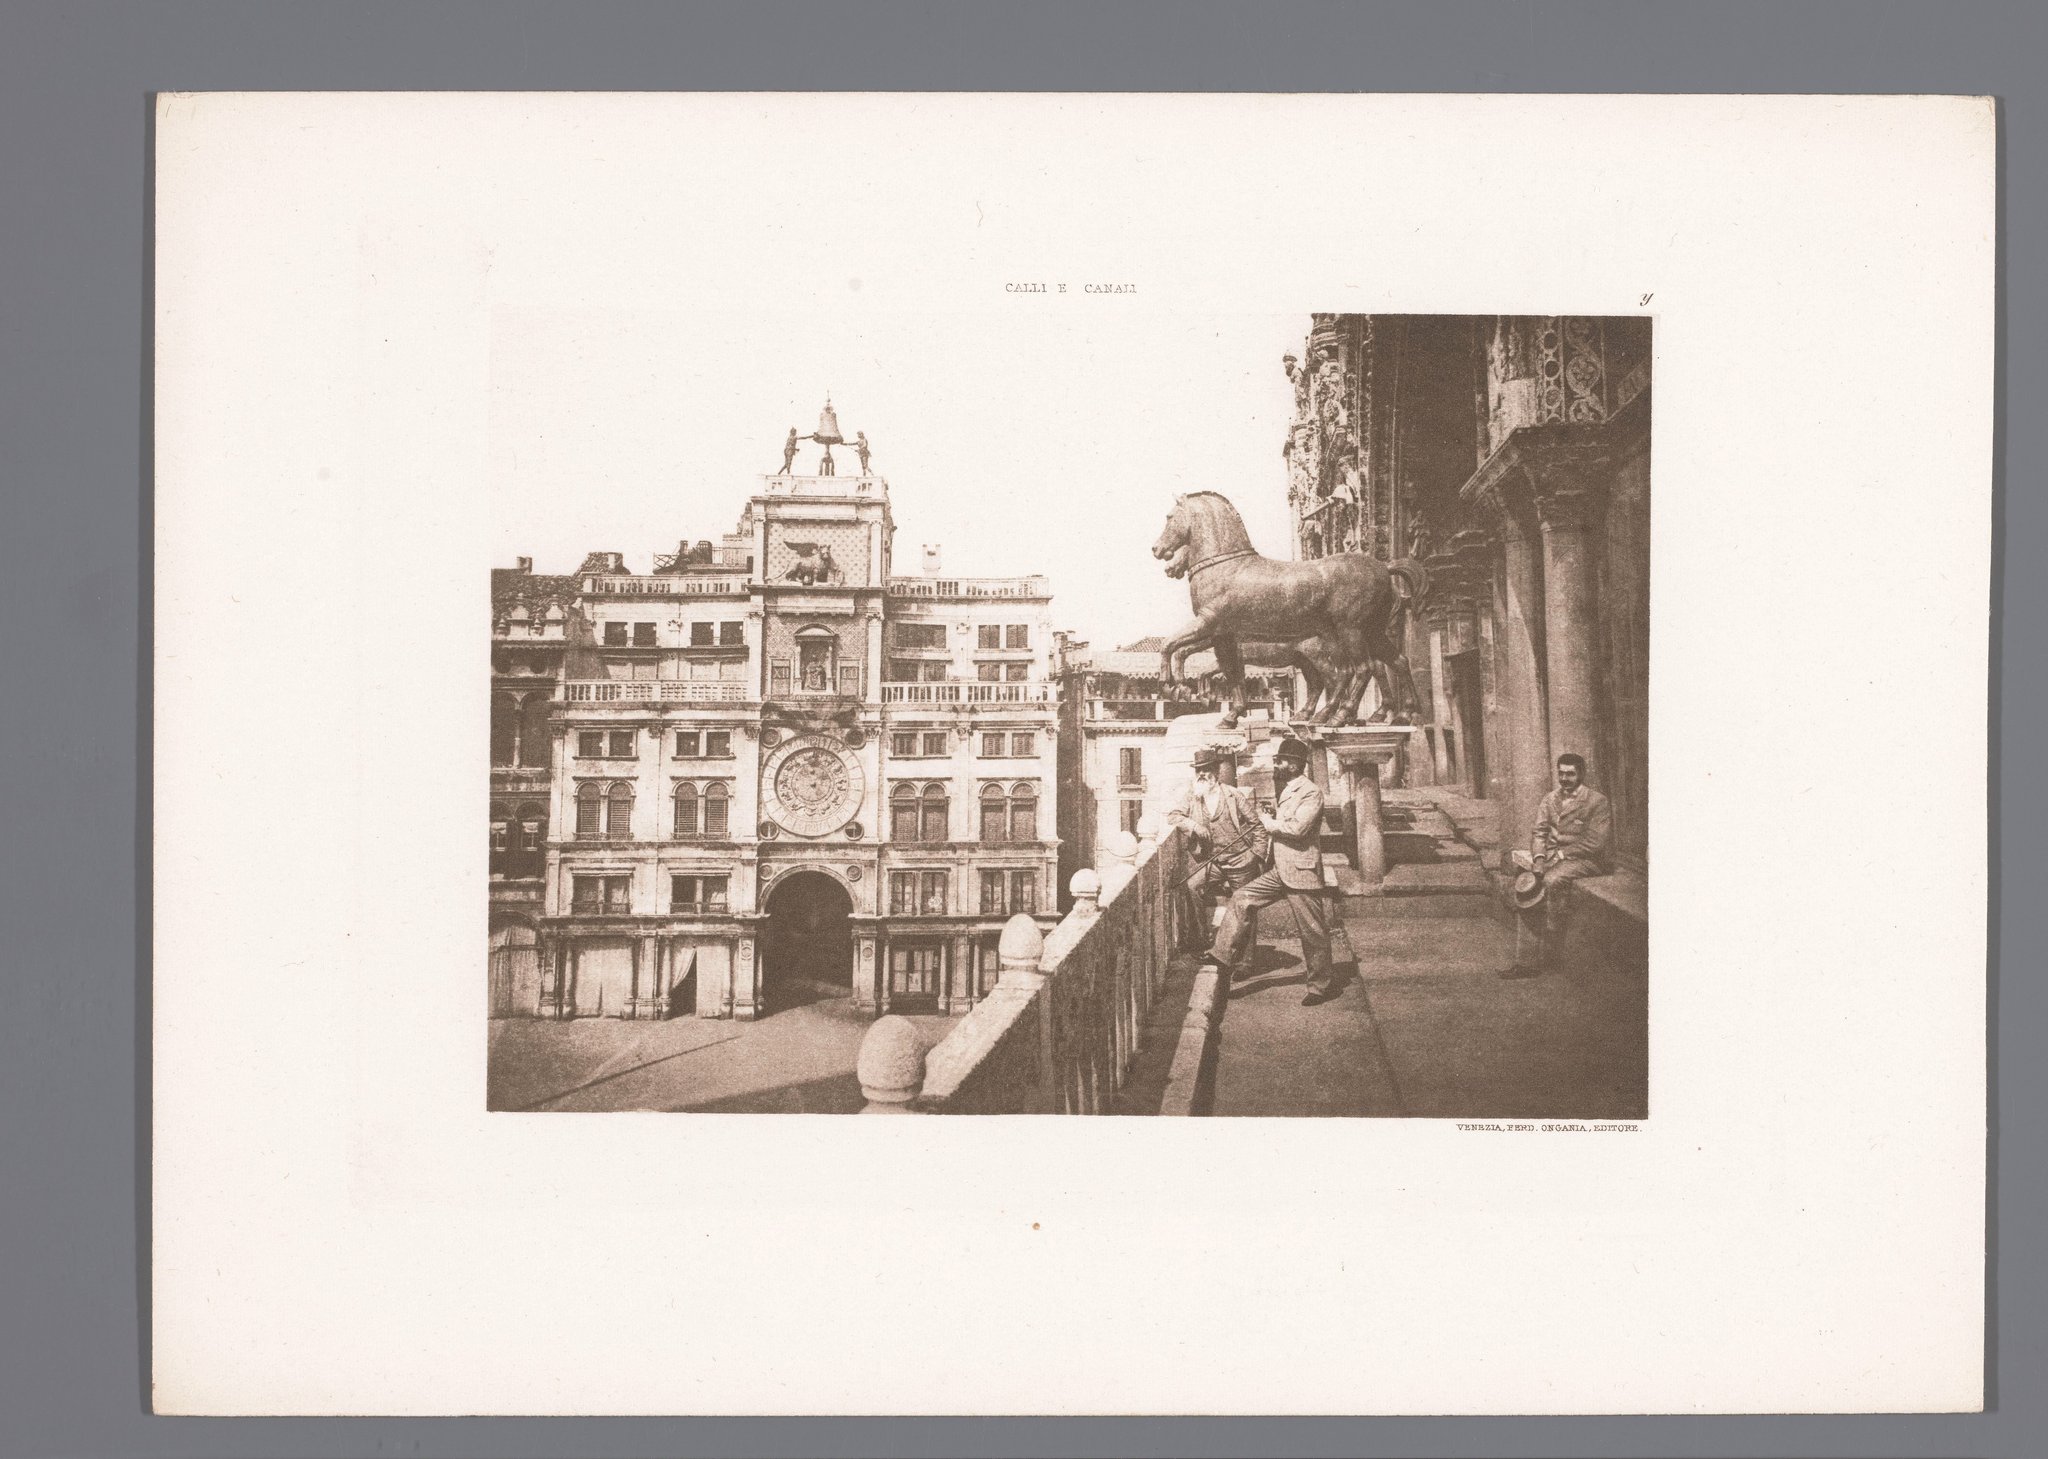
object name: page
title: Gezicht op de Torre dell'Orologio vanaf een balkon van de San Marco in Venetië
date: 1888-1898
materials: paper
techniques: photoaquatint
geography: st. mark's basilica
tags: tower, clock tower ~ monumental adornment, loggia, verandah, porch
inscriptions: inscription: ‘y’